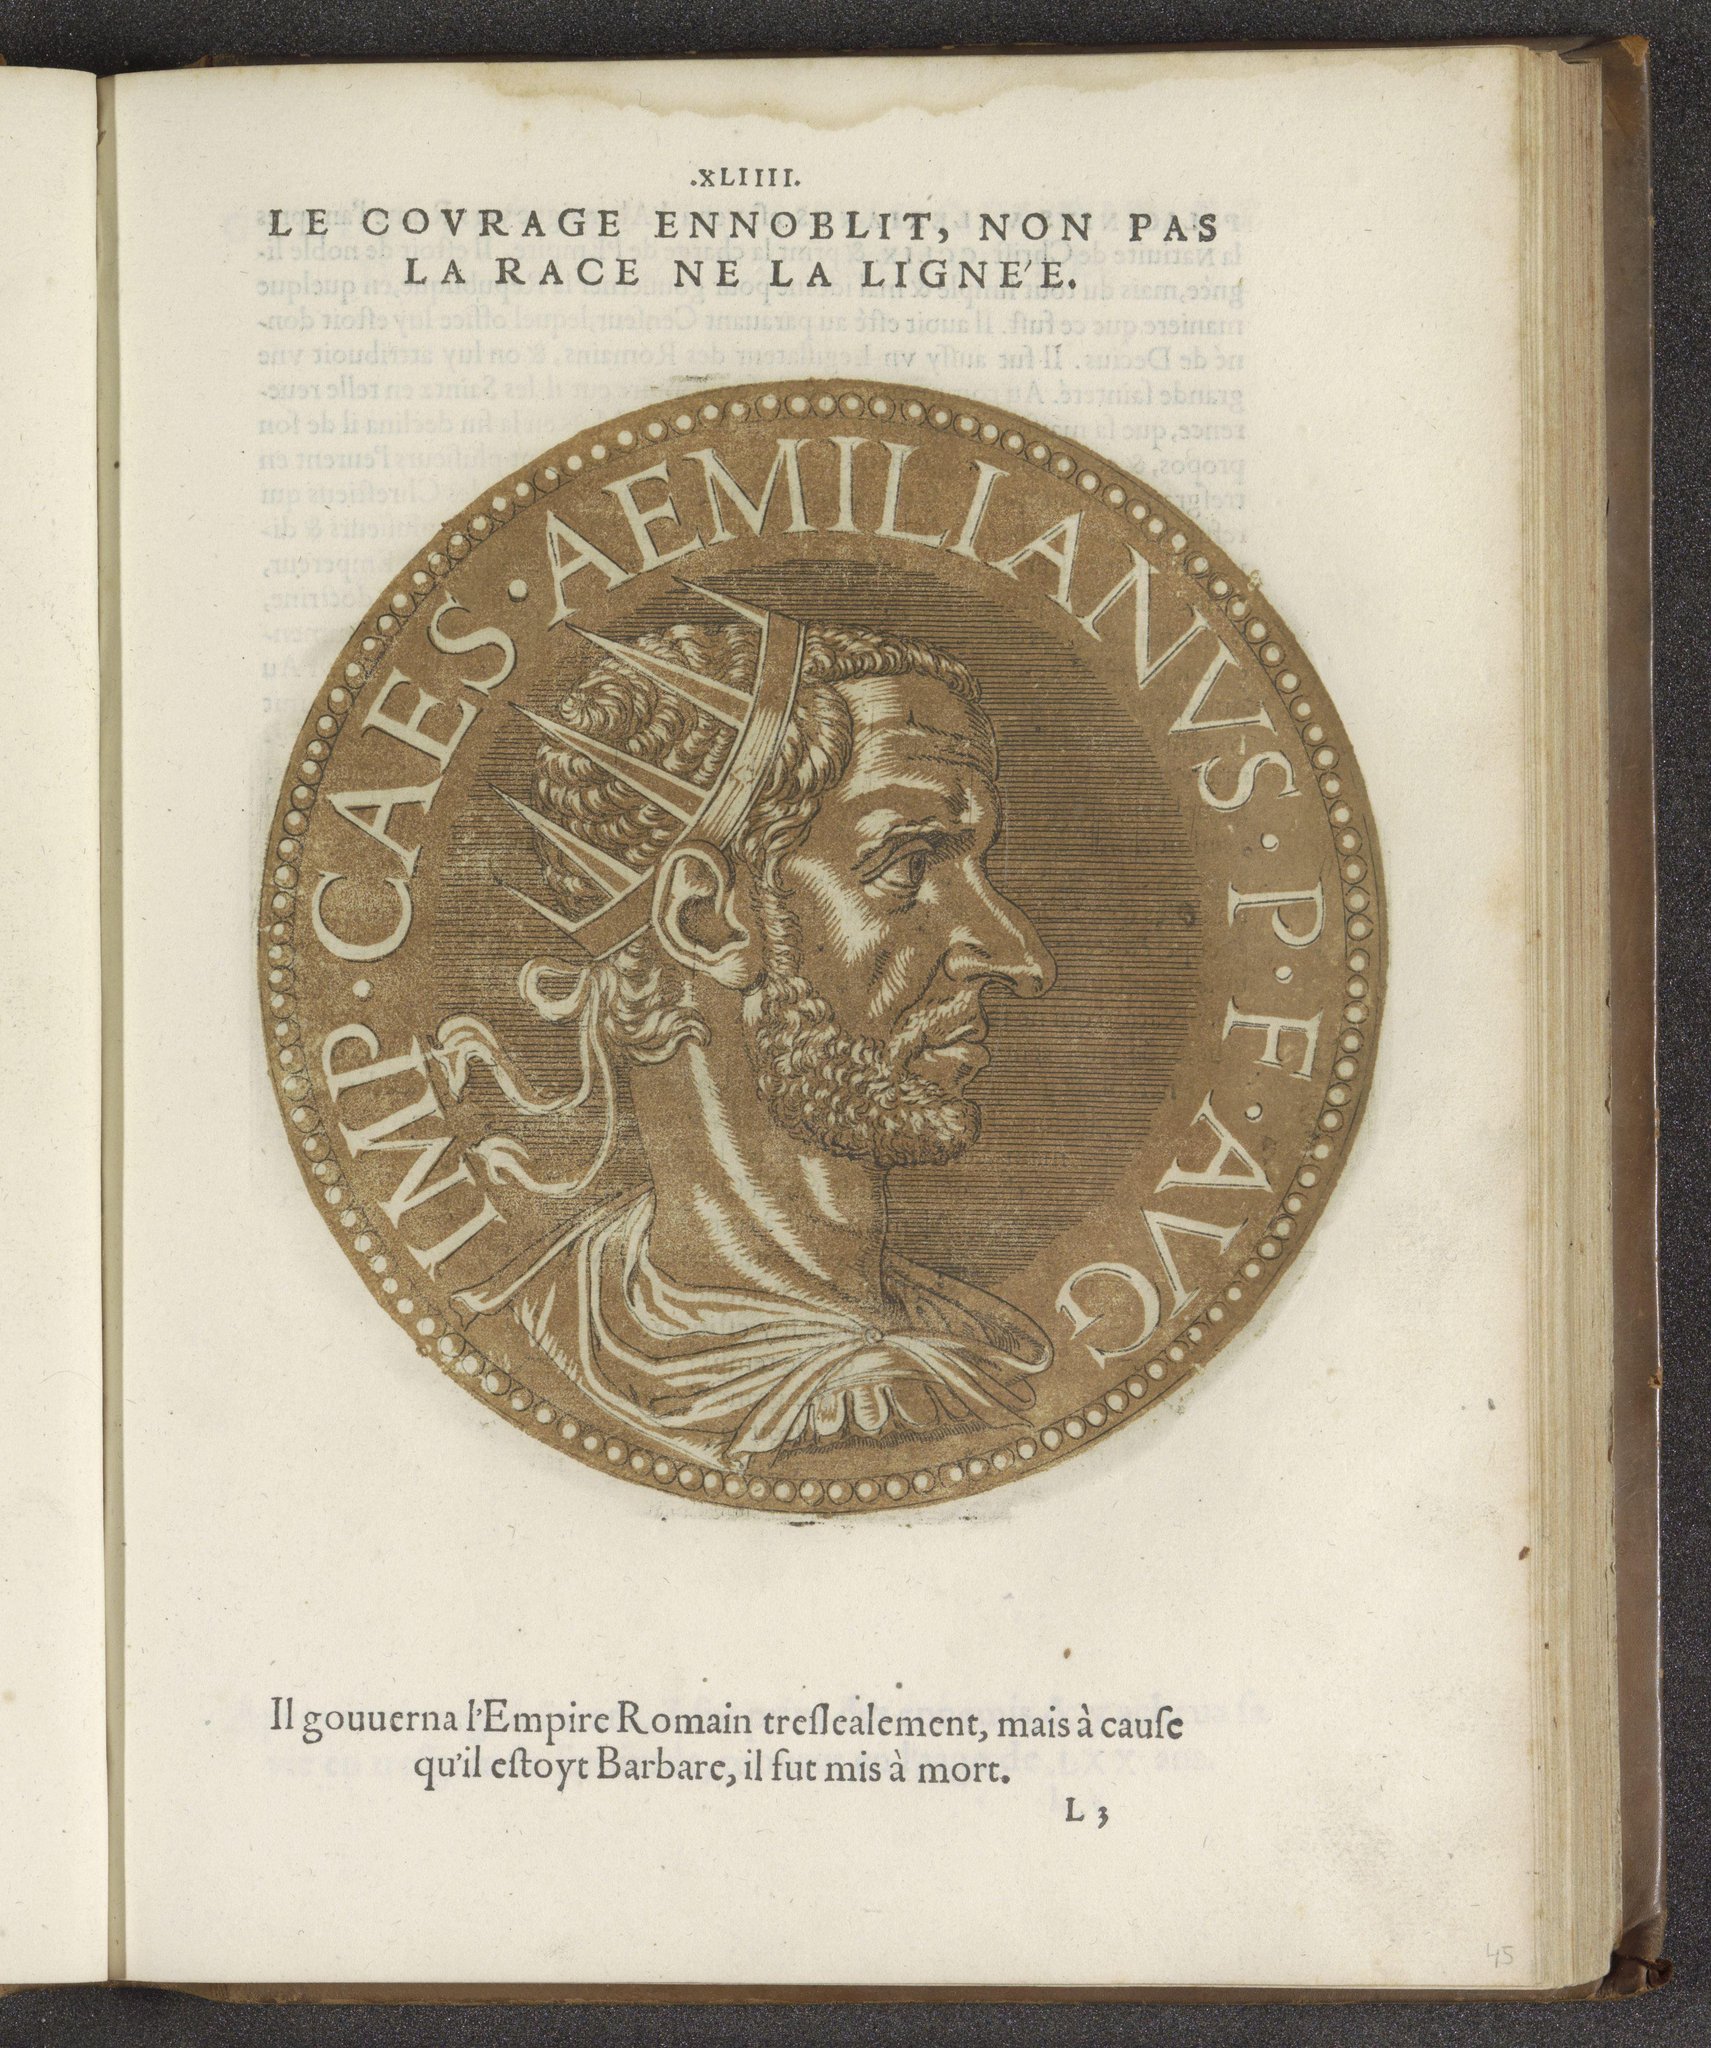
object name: page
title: Les images presque de tous les empereurs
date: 1557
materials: paper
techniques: woodcut, etching, letterpress printing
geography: antwerp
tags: emperor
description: Portret van keizer Aemilianus, op een munt met randschrift. De prent maakt deel uit van een boek over de keizers vanaf Julius Caesar tot en met Karel V en zijn broer Ferdinand.